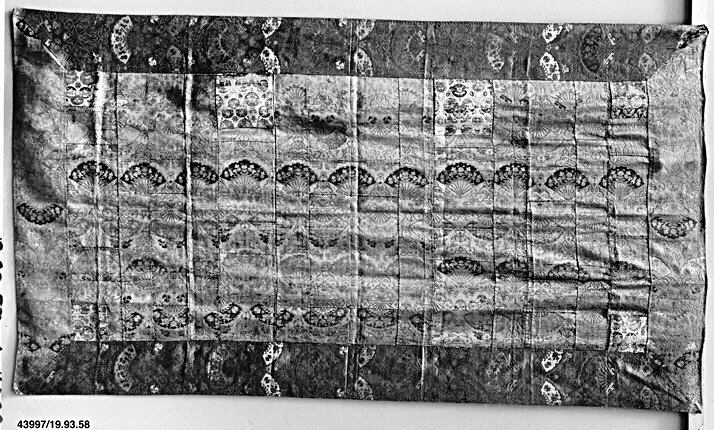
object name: robe, priest's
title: Priest's Robe (Shichijō)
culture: japanese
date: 1624-1644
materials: silk